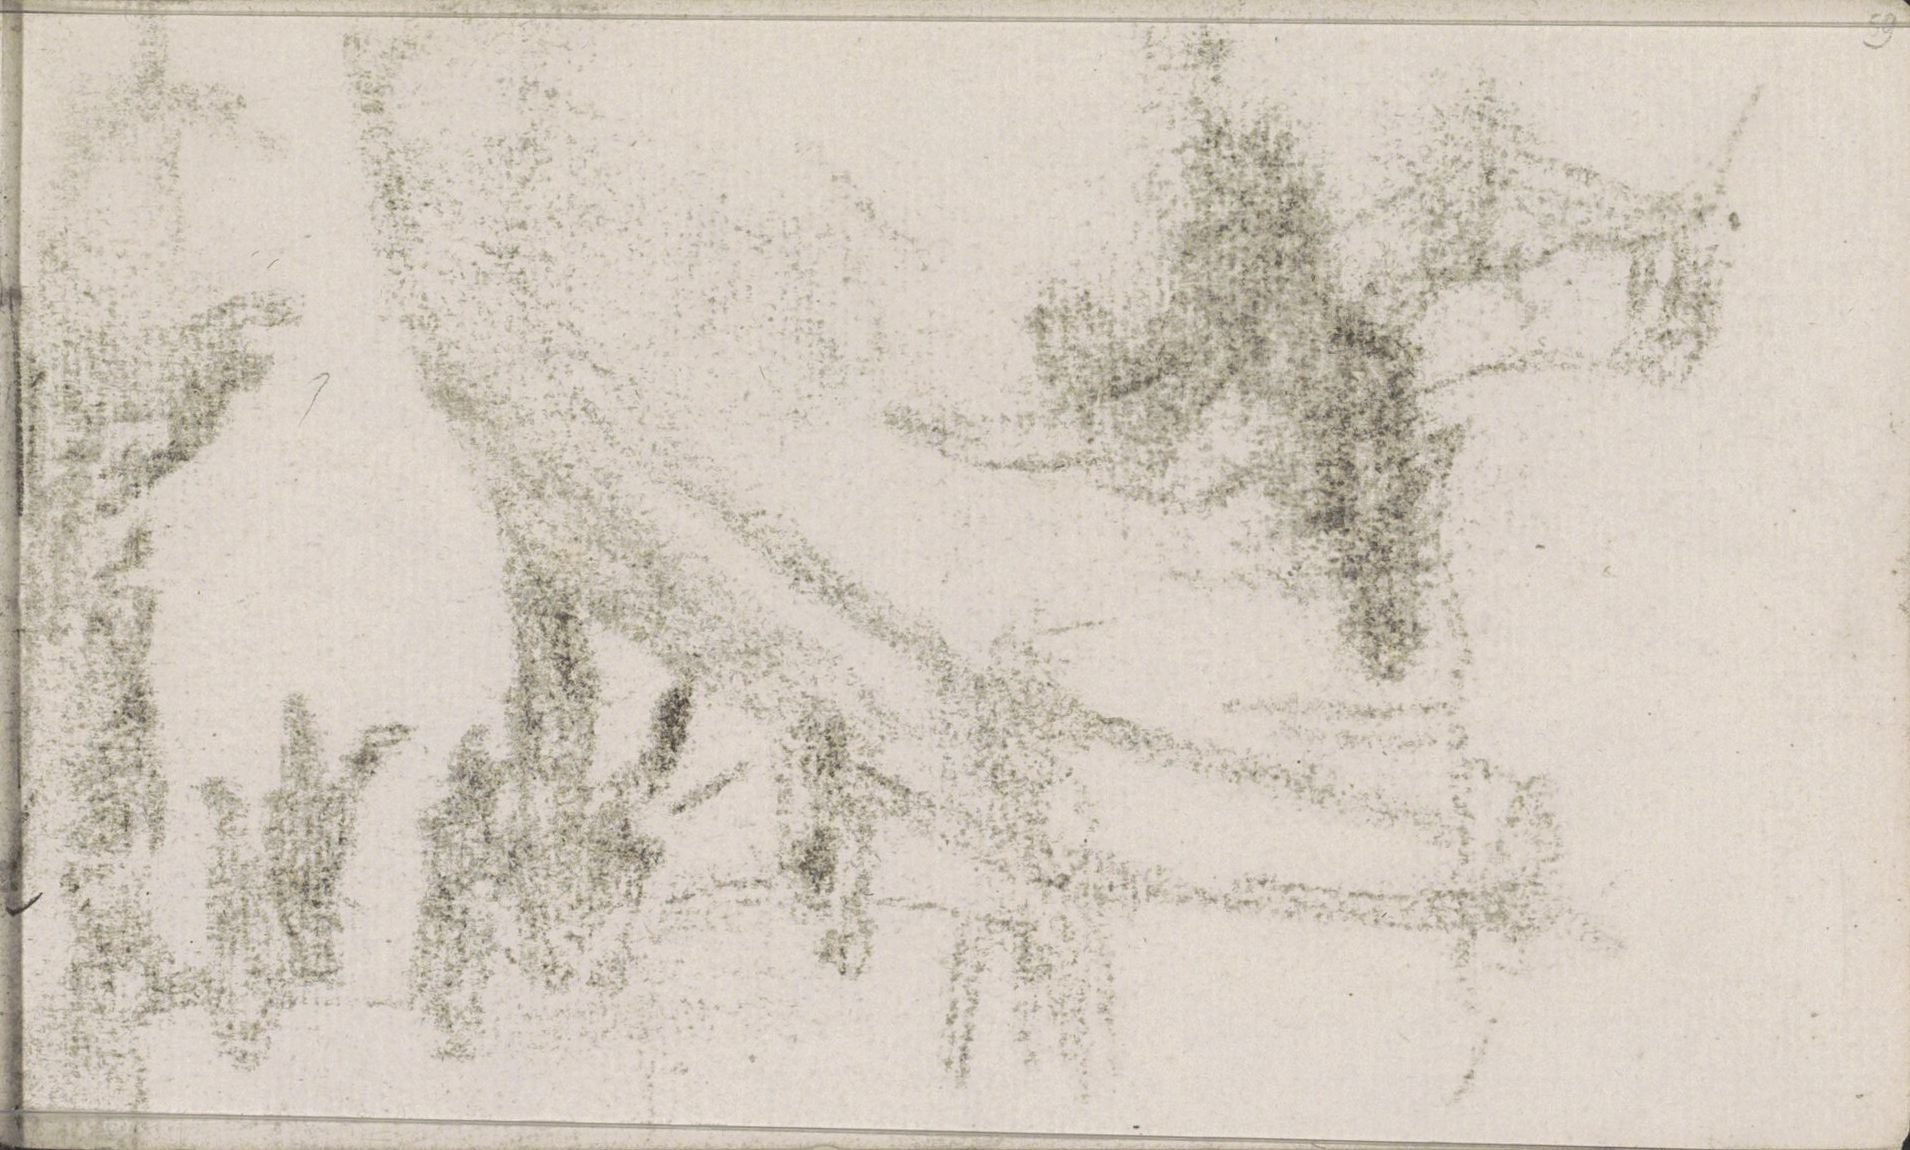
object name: sketchbook leaf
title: Abklatsch van de krijttekening op pagina 58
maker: isaac israels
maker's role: draughtsman, painter, print maker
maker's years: 1865-1934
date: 1875-1934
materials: paper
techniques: printmaking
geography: the hague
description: Pagina 59 uit schetsboek XLVIII met 62 pagina's.